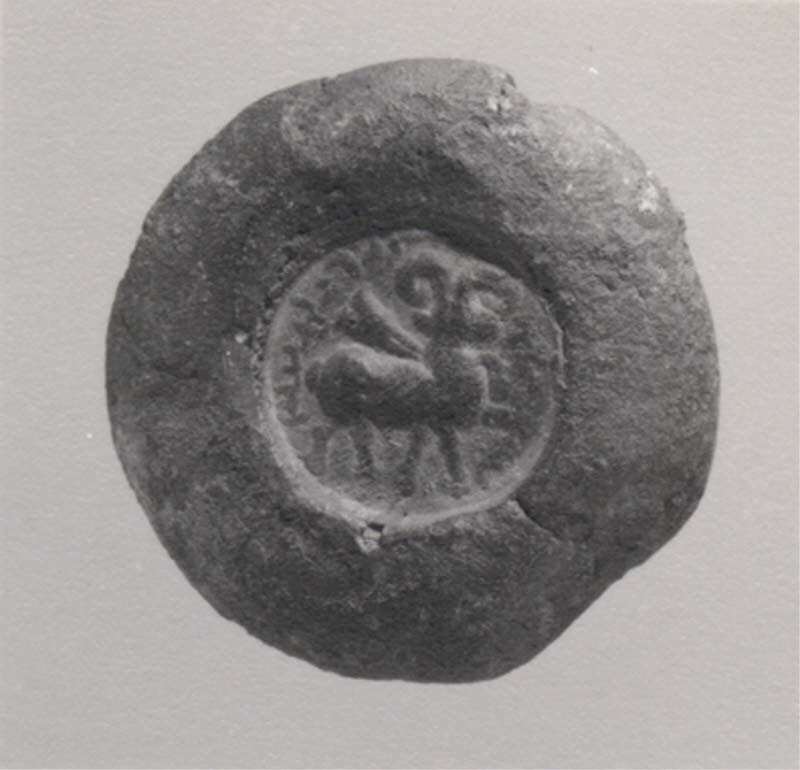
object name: sealing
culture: sasanian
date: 601-700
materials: clay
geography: iran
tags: animals